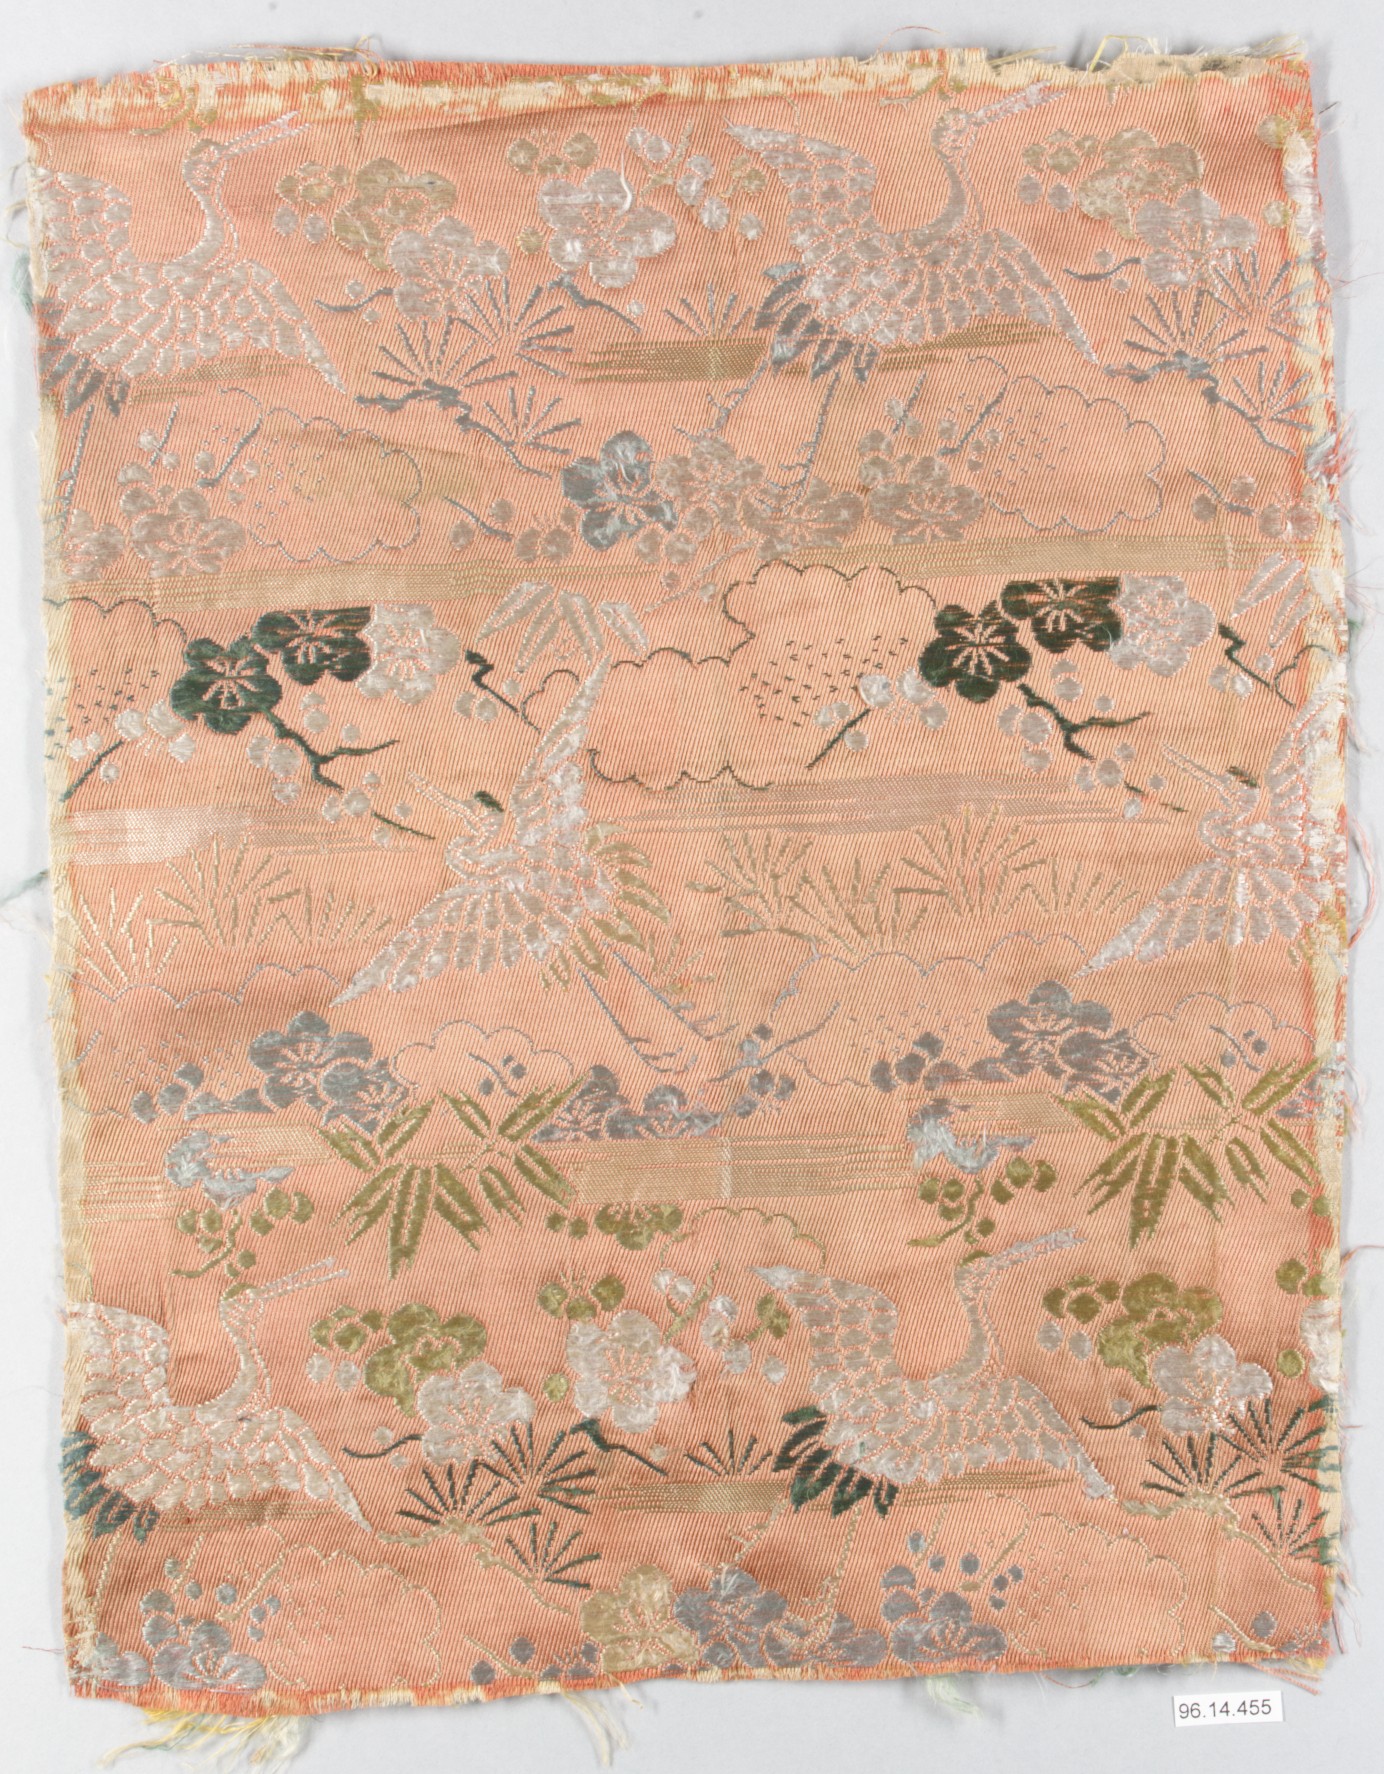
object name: piece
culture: japanese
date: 1601-1700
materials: silk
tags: flowers